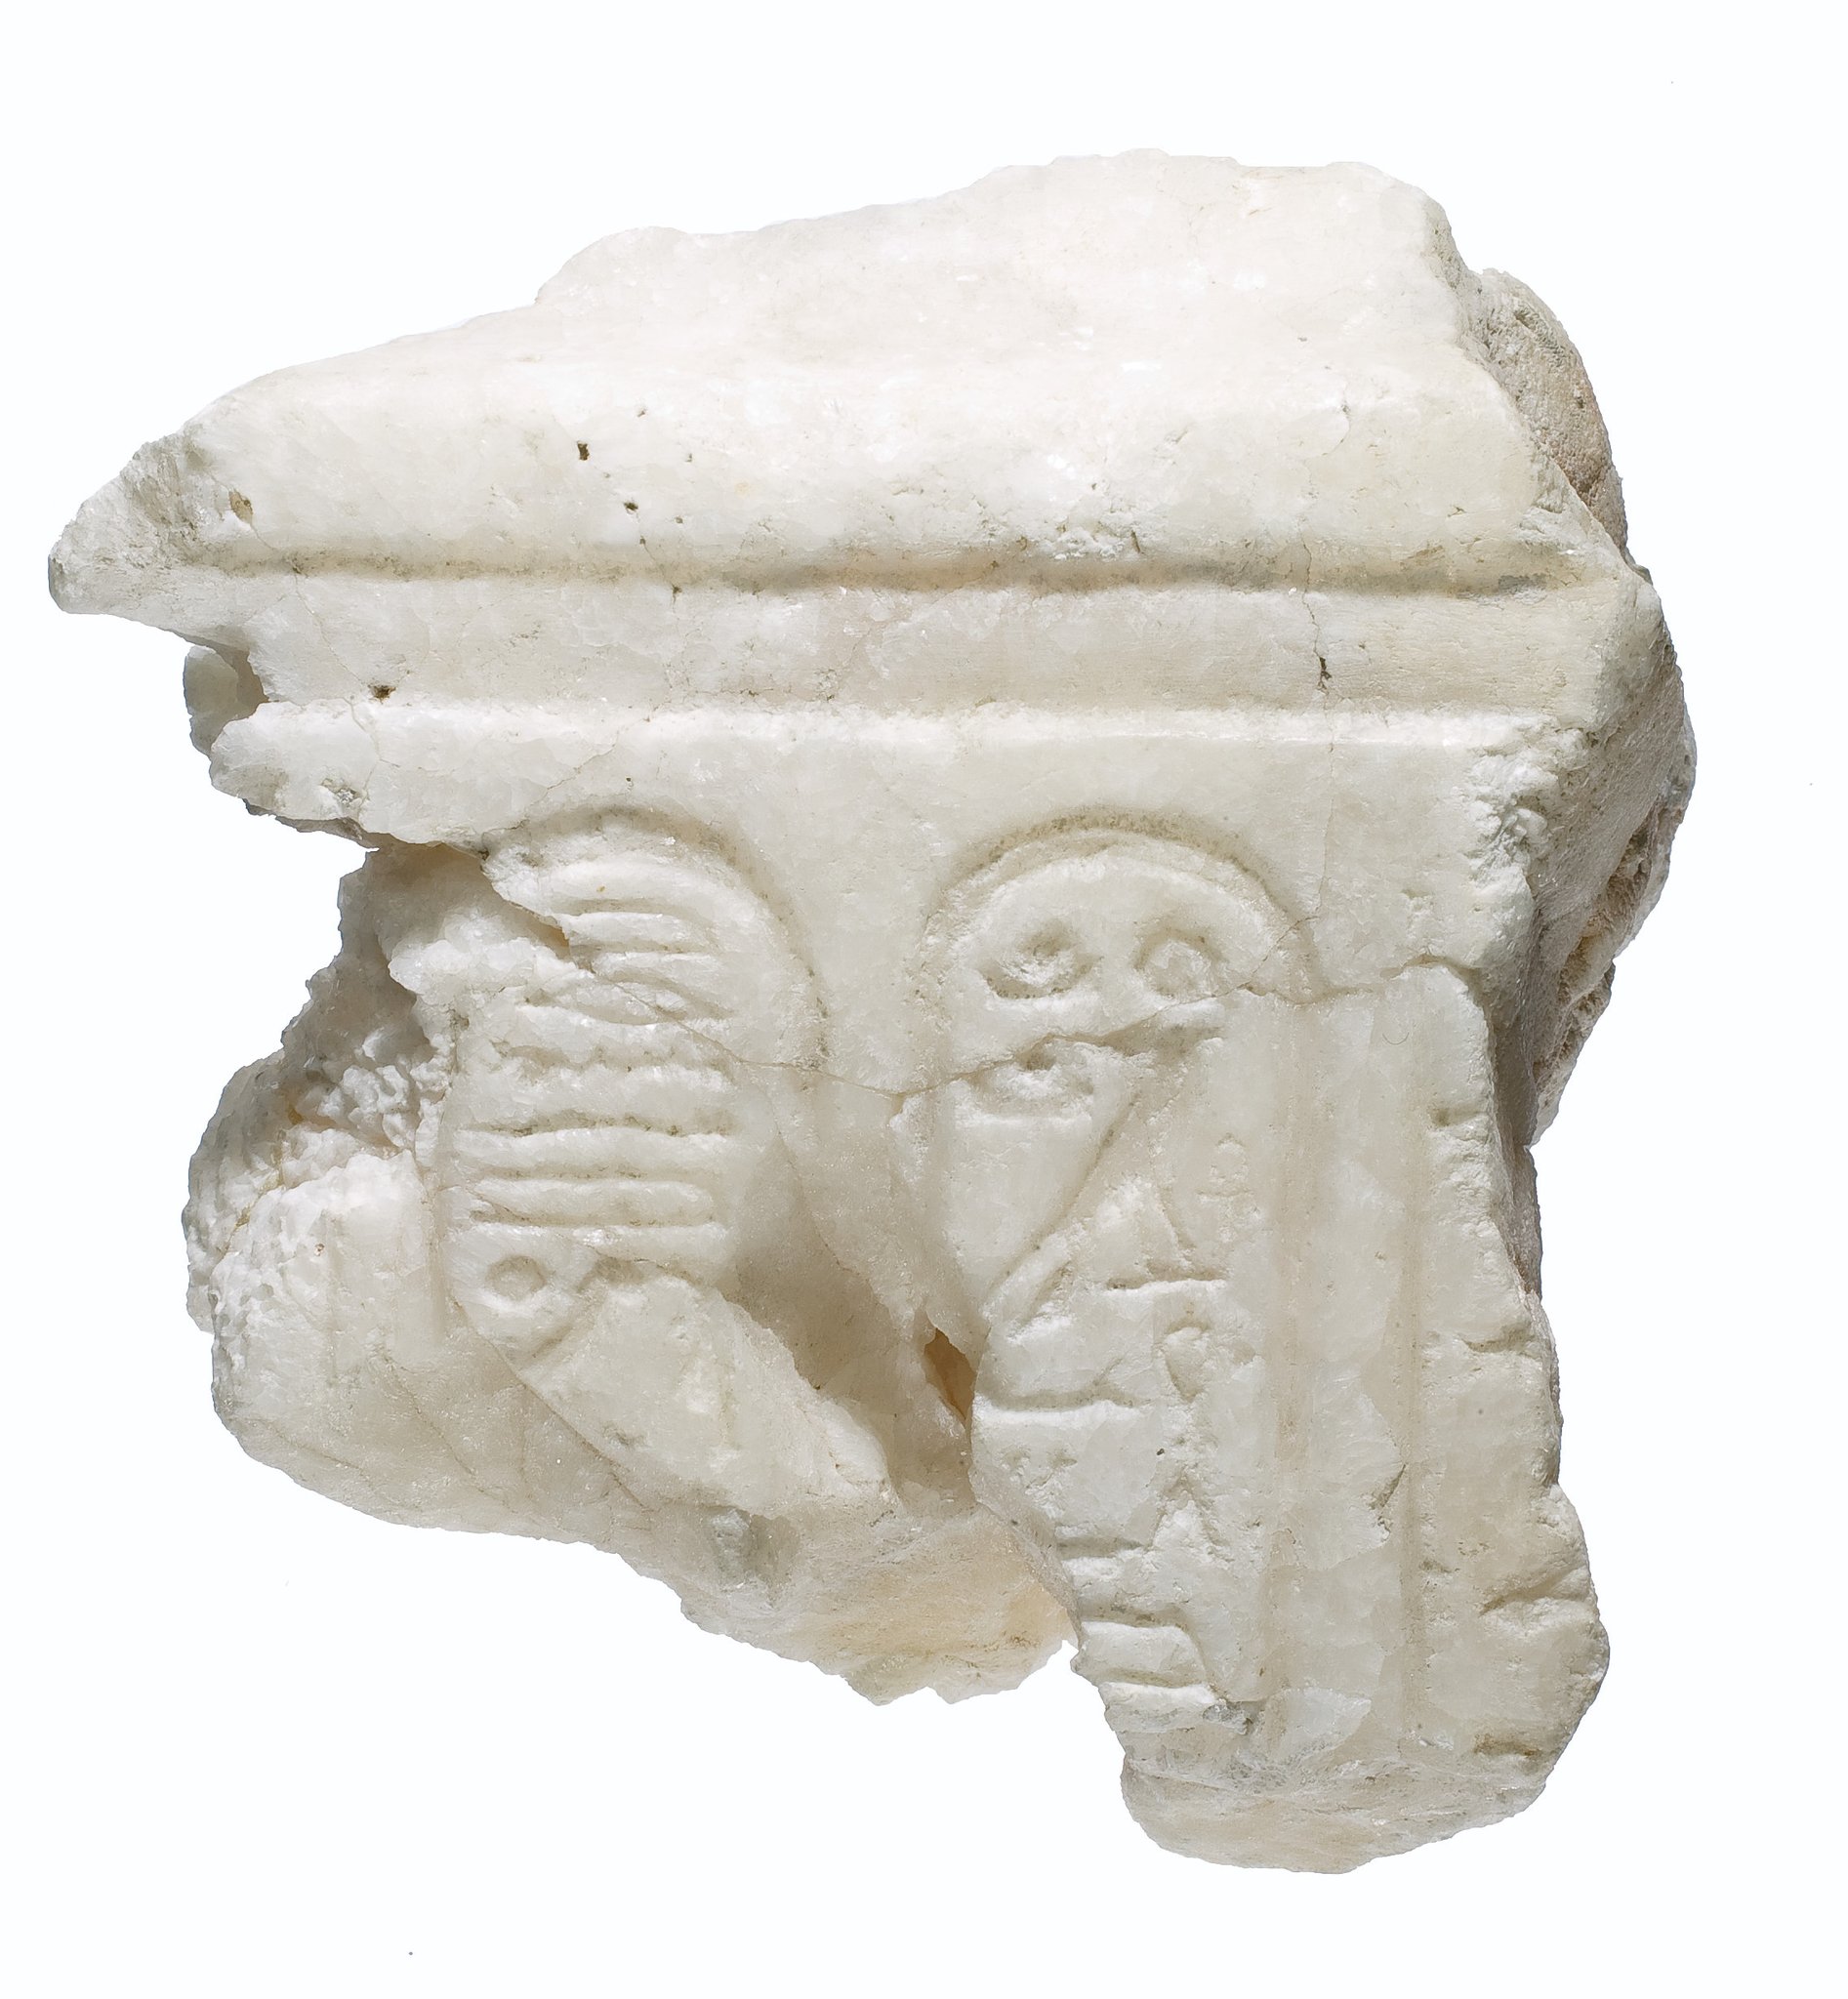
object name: balustrade section, aten cartouch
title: Balustrade fragment with cartouches of the Aten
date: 1352-1336 BCE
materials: stone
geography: egypt